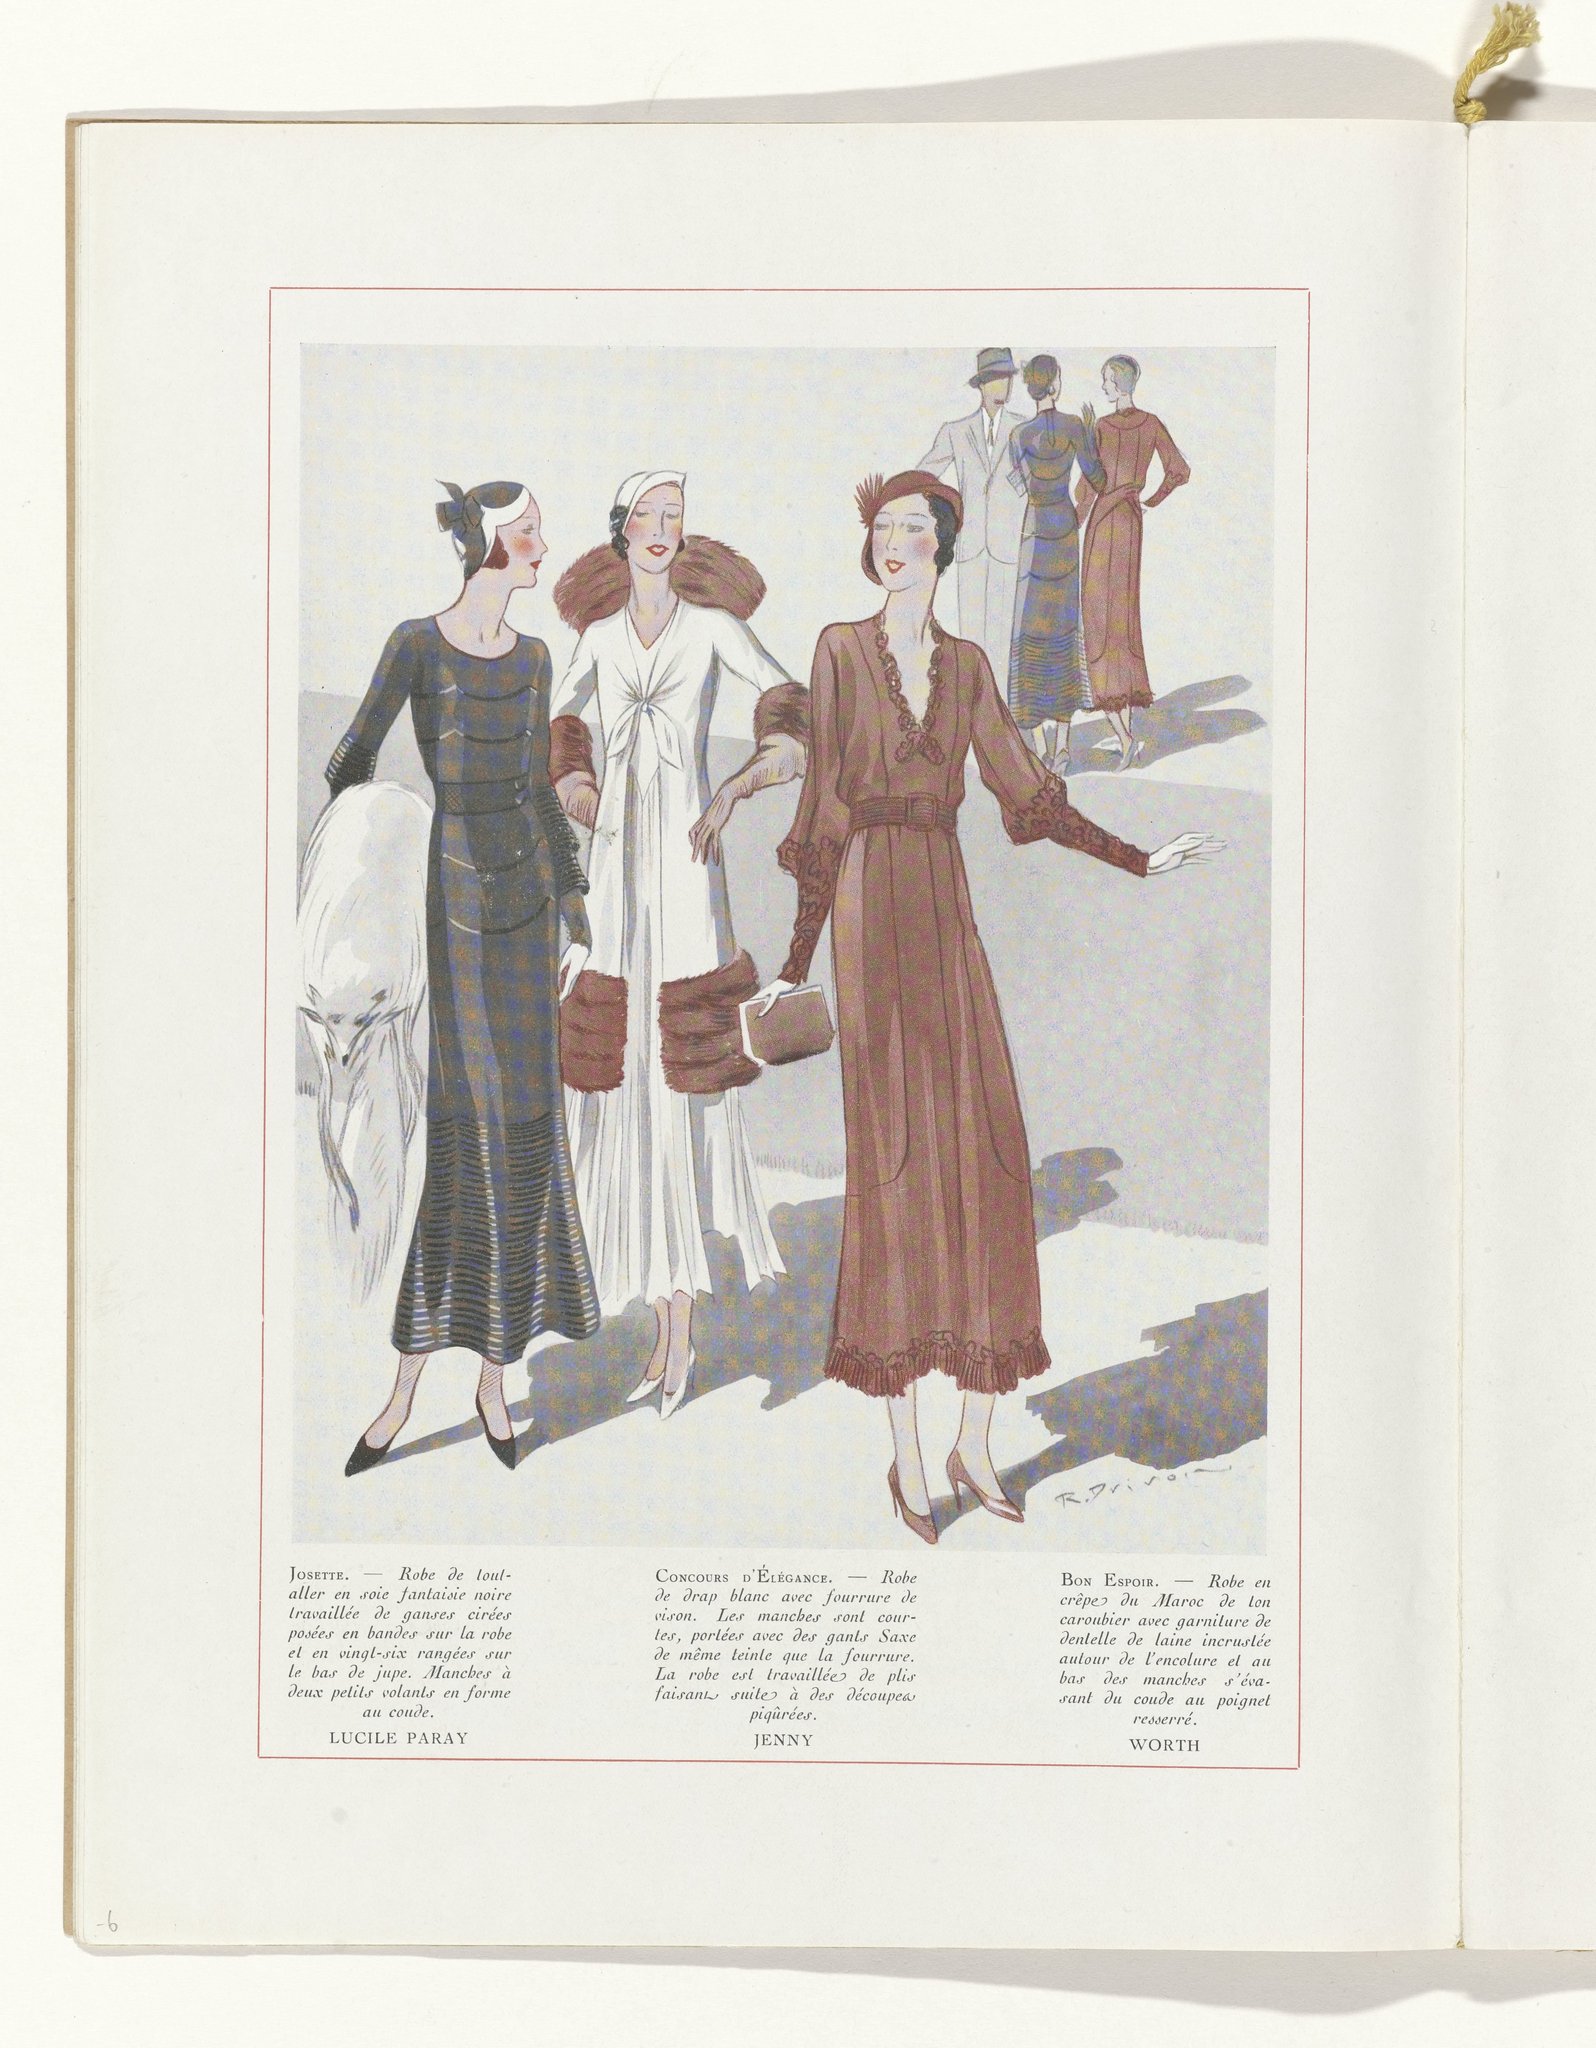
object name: magazine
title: Art - Goût - Beauté, Feuillets de l' élégance féminine, Novembre 1931, No. 135, 12e Année, p. 6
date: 1931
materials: paper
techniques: printing, photography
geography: paris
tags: gloves, mittens (long gloves) (+ women's clothes), bag (handbag) (+ women's clothes), lace (+ women's clothes), border, ribbon, braid (+ fur used for clothes), fashion plates, head-gear: hat (+ women's clothes), dress, gown (+ women's clothes), clothing for the upper part of the body (shawl) (+ fur used for clothes)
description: Links: japon van zwarte zijde van Lucile Paray. Midden: japon van wit laken en nerts, van het modehuis Jenny. Rechts: japon van crêpe gegarneerd met wollen kant, van Worth. Pagina uit het modetijdschrift Art-Goût-Beauté (1920-1933).